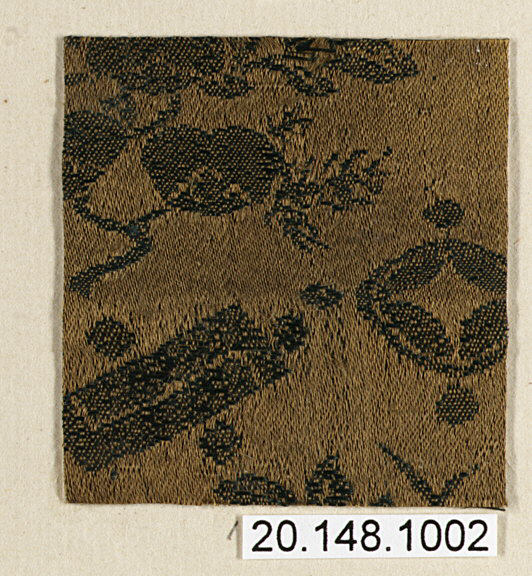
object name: piece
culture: japanese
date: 1801-1900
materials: silk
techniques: compound weave